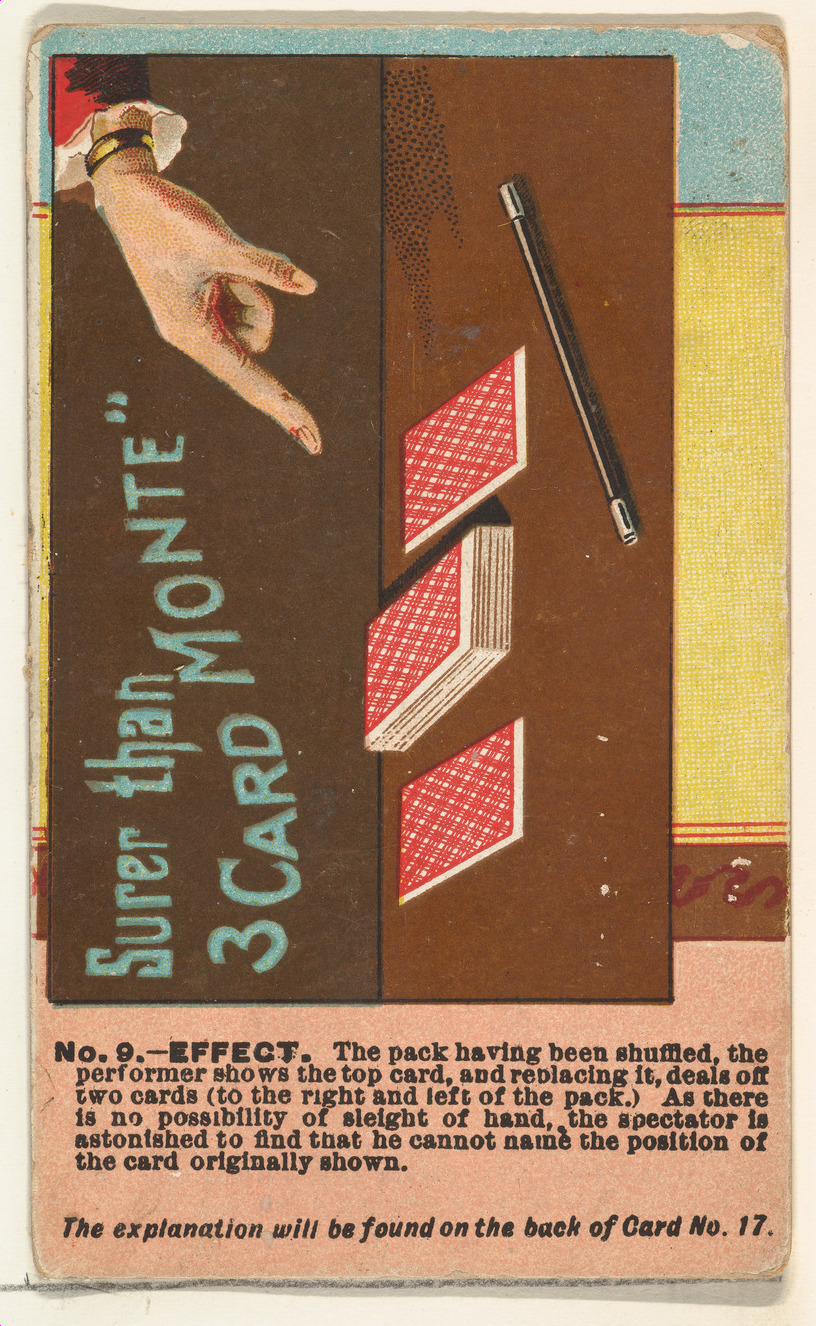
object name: print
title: Number 9, Surer than Three Card Monte, from the Tricks with Cards series (N138) issued by W. Duke, Sons & Co. to promote Honest Long Cut Tobacco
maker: w. duke, sons & co.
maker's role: publisher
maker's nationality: american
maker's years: 1870-1920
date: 1887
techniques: color lithograph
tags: magic,playing cards